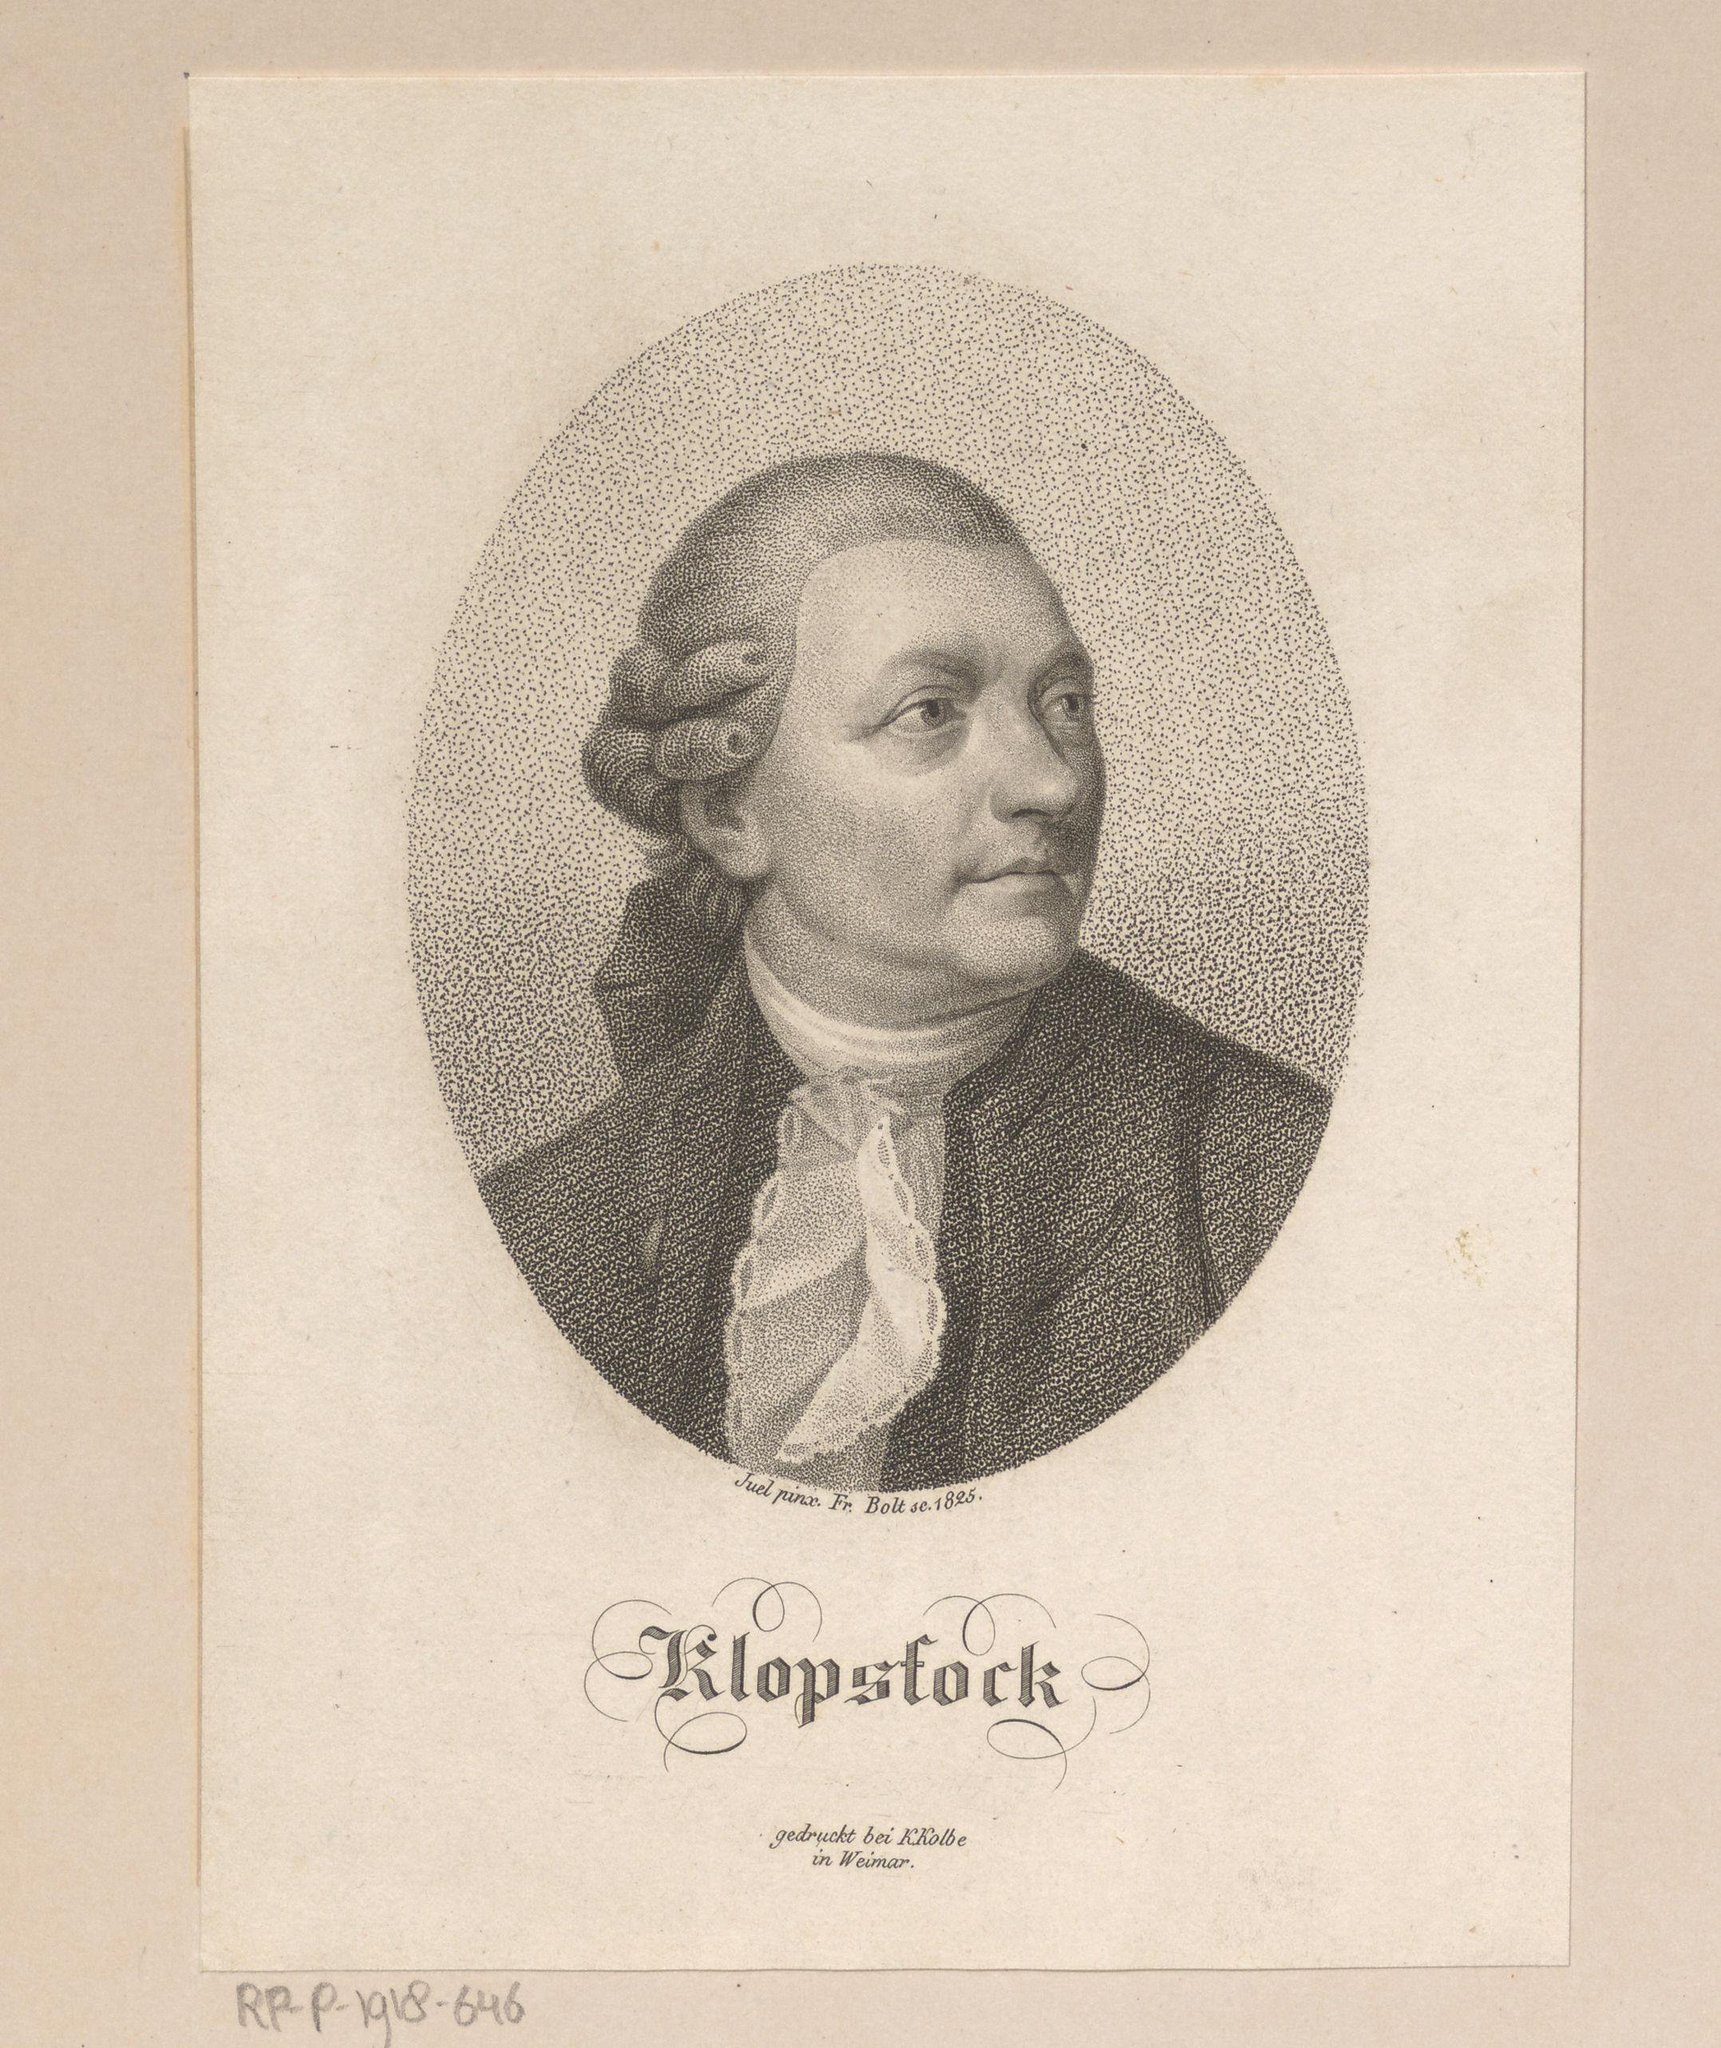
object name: print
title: Portret van Friedrich Gottlieb Klopstock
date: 1825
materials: paper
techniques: engraving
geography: weimar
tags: historical persons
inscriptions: collector's mark: Lugt 2233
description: Prent mogelijk uit: Doering, Heinrich. Klopstock's Leben. Weimar: Wilhelm Hoffmann, 1825.